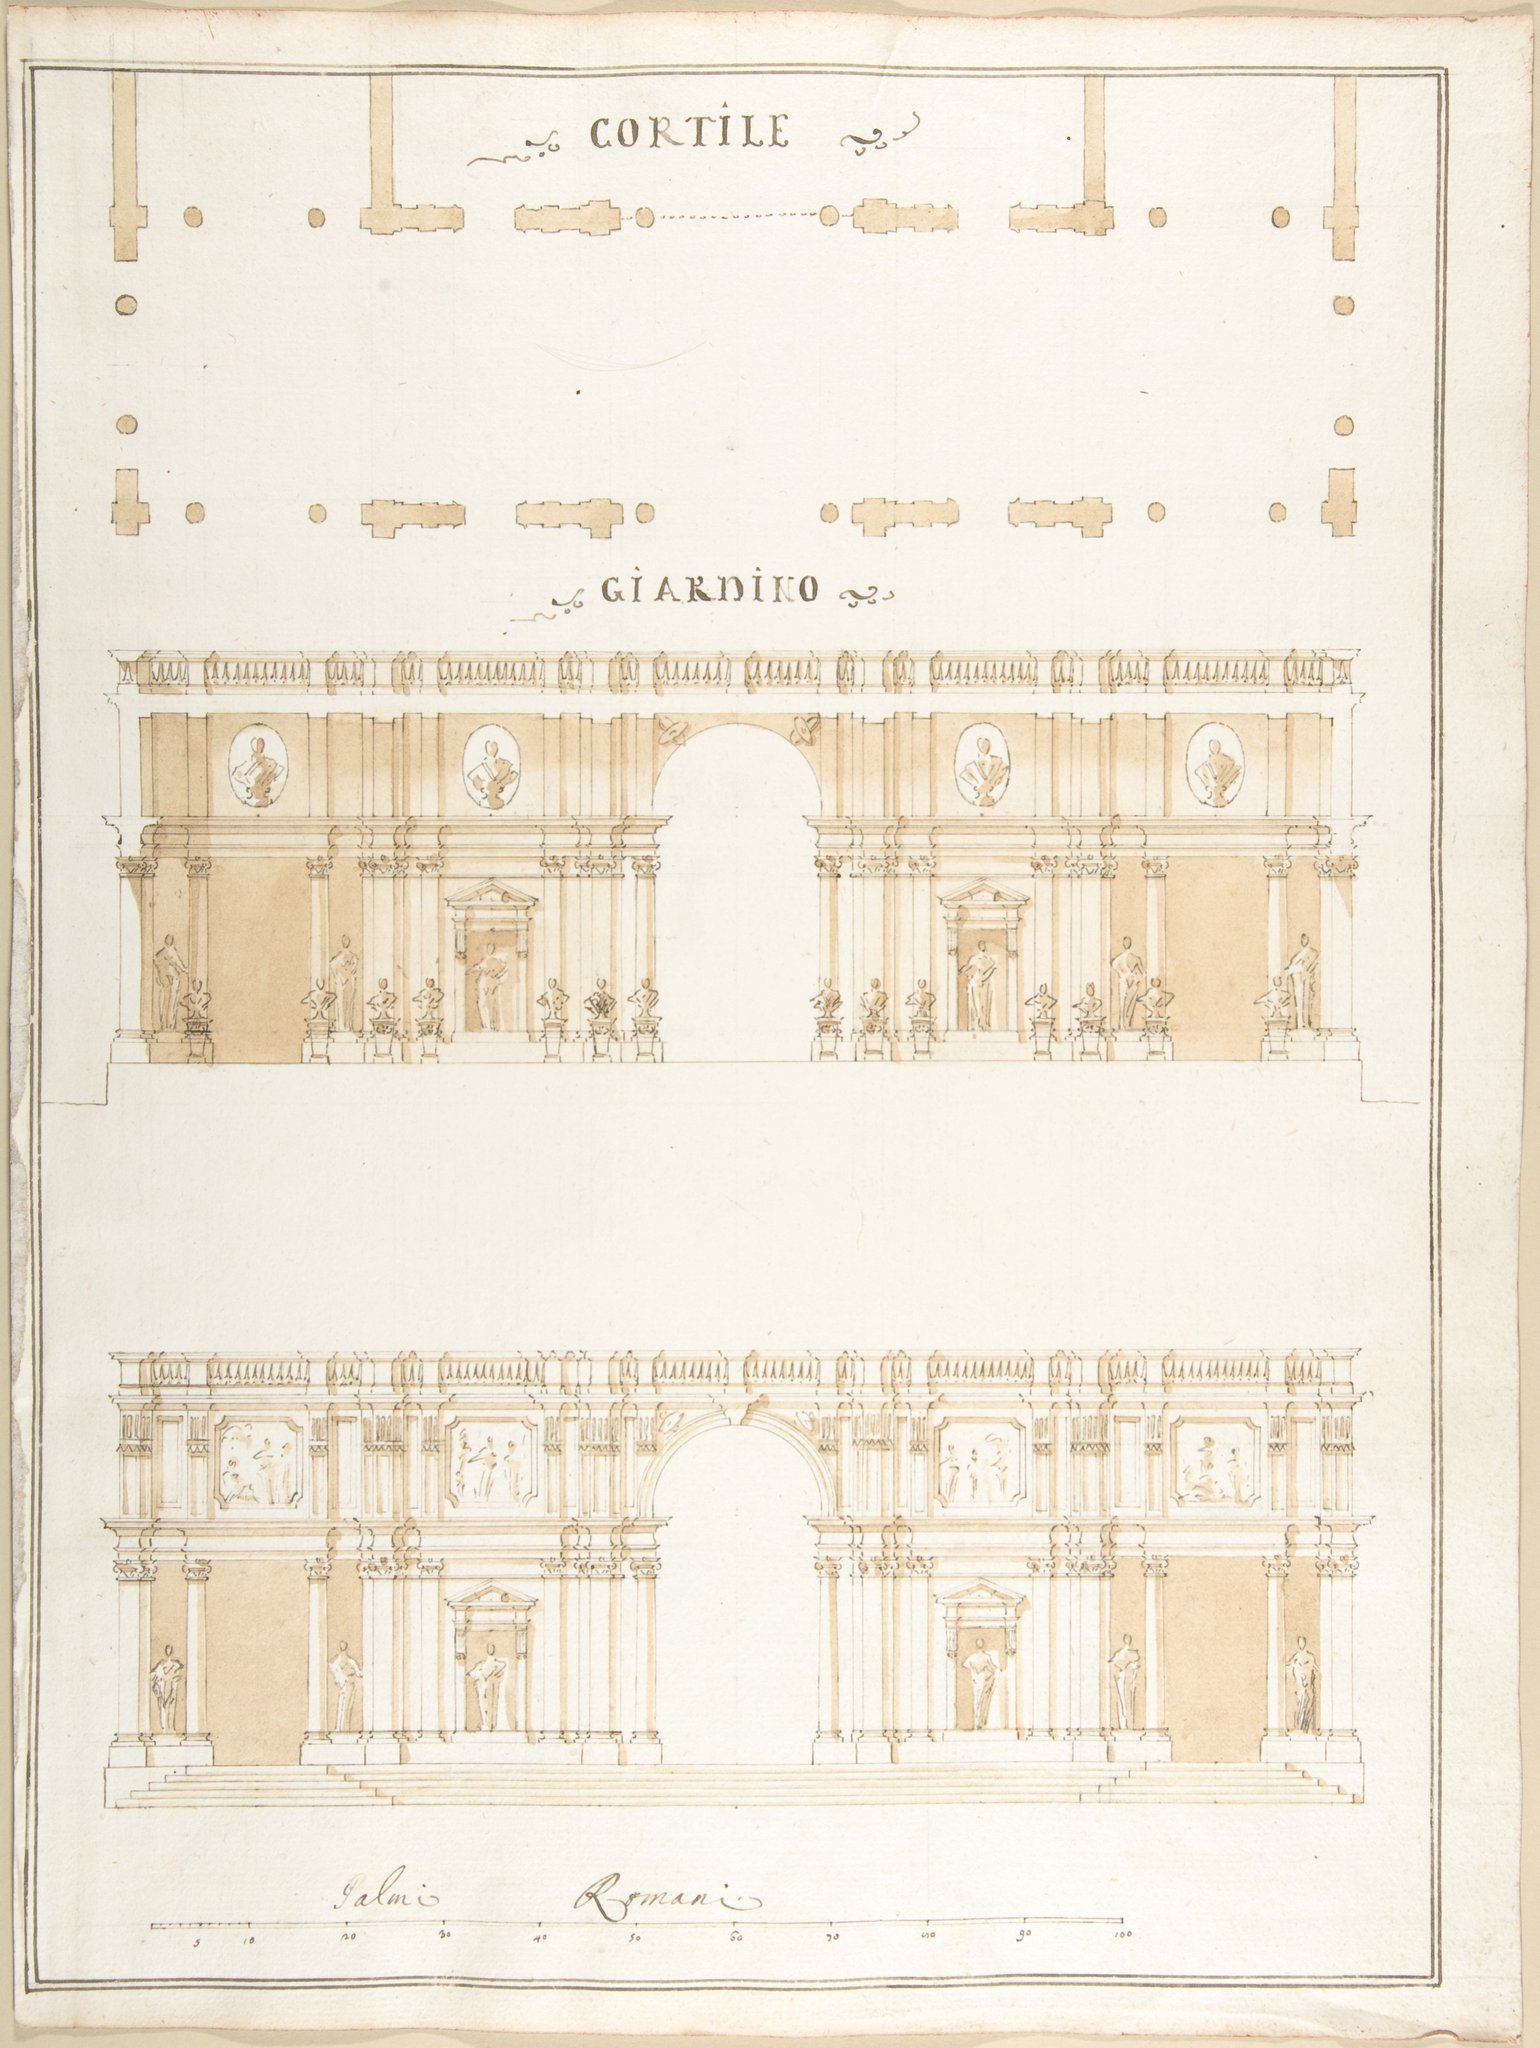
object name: drawing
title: Plan, Section and Exterior Elevation of a Villa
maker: pietro paolo coccetti (cocchetti)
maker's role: artist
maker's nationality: italian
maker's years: 1710-1727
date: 1710-1727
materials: graphite, ink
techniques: brush, pen, wash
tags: architecture